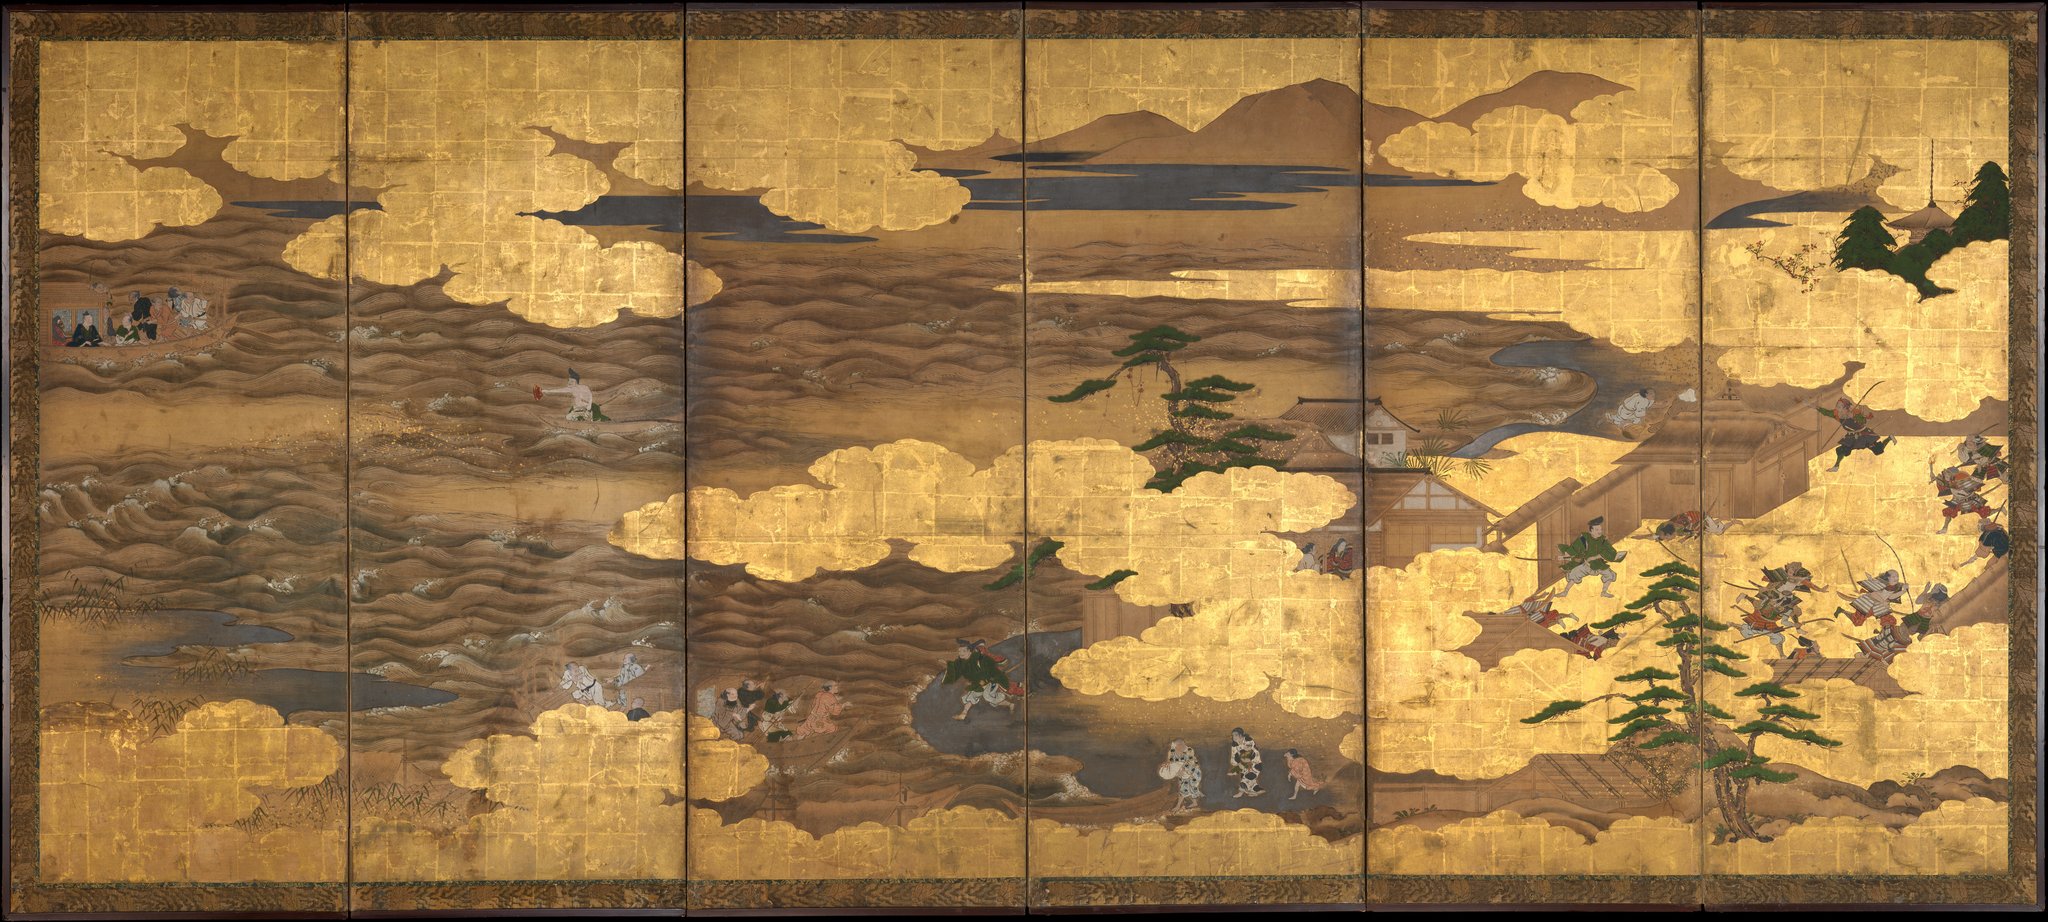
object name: screen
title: “Takebun,” from the Musical Drama “The New Piece” (Shinkyoku)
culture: japanese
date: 1601-1633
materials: gold, ink, panel, paper, silver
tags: trees